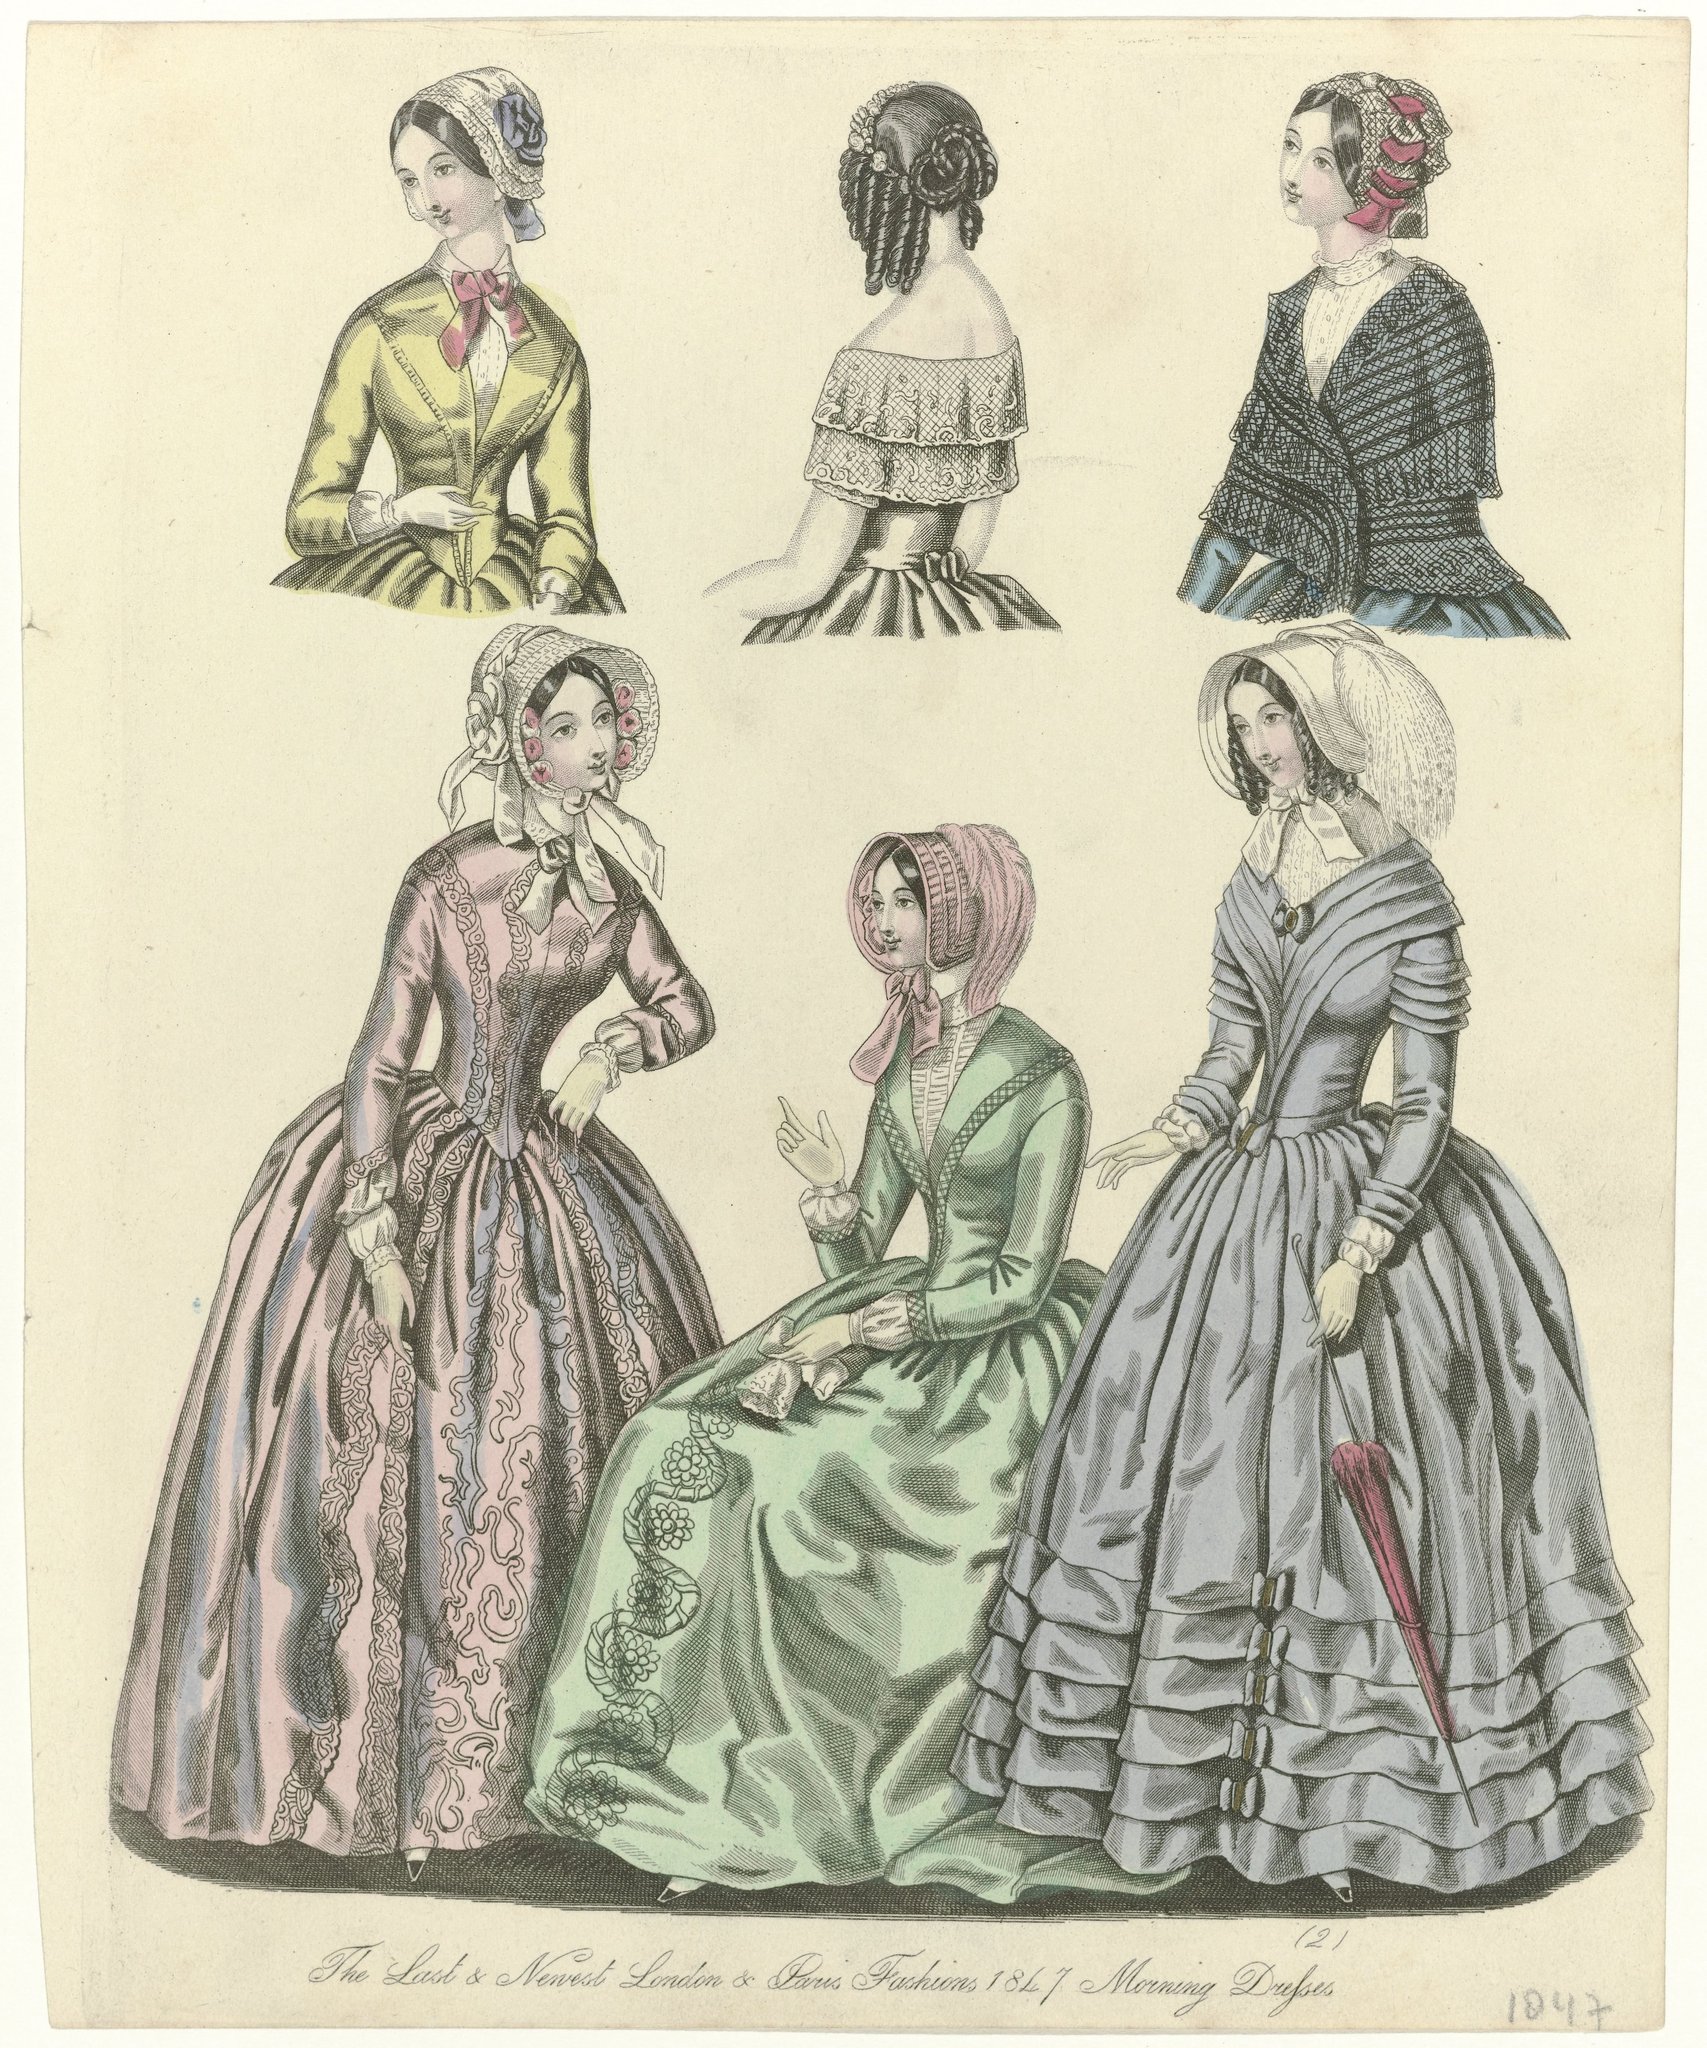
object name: fashion print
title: The World of Fashion, 1847 : The Last & Newest (...)Morning Dresses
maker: Anonymous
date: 1847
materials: paper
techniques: etching, hand coloring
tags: clothing for the upper part of the body (+ women's clothes), handkerchief (+ women's clothes), dress, gown: morning dress (+ women's clothes), neck-gear ~ clothing (bertha) (+ women's clothes), clothing for the upper part of the body (mantelet) (+ women's clothes), head-gear: cap (+ women's clothes), fashion plates, head-gear: hat (+ women's clothes), gloves, mittens, etc. (+ women's clothes), parasol, sunshade (+ women's clothes)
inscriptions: caption: ‘The Last & Newest London & Paris Fashions 1847 Morning Dresses (2)’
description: De laatste en nieuwste modes van 1847 uit Londen en Parijs. Ochtendjaponnen met wijde geplooide rokken. Nauwsluitende mouwen met geplooide ondermouwen. Boven: japon met lange mouwen, avondjapon en kleine schoudermantel. Prent uit het modetijdschrift The World of Fashion (1824-1891).